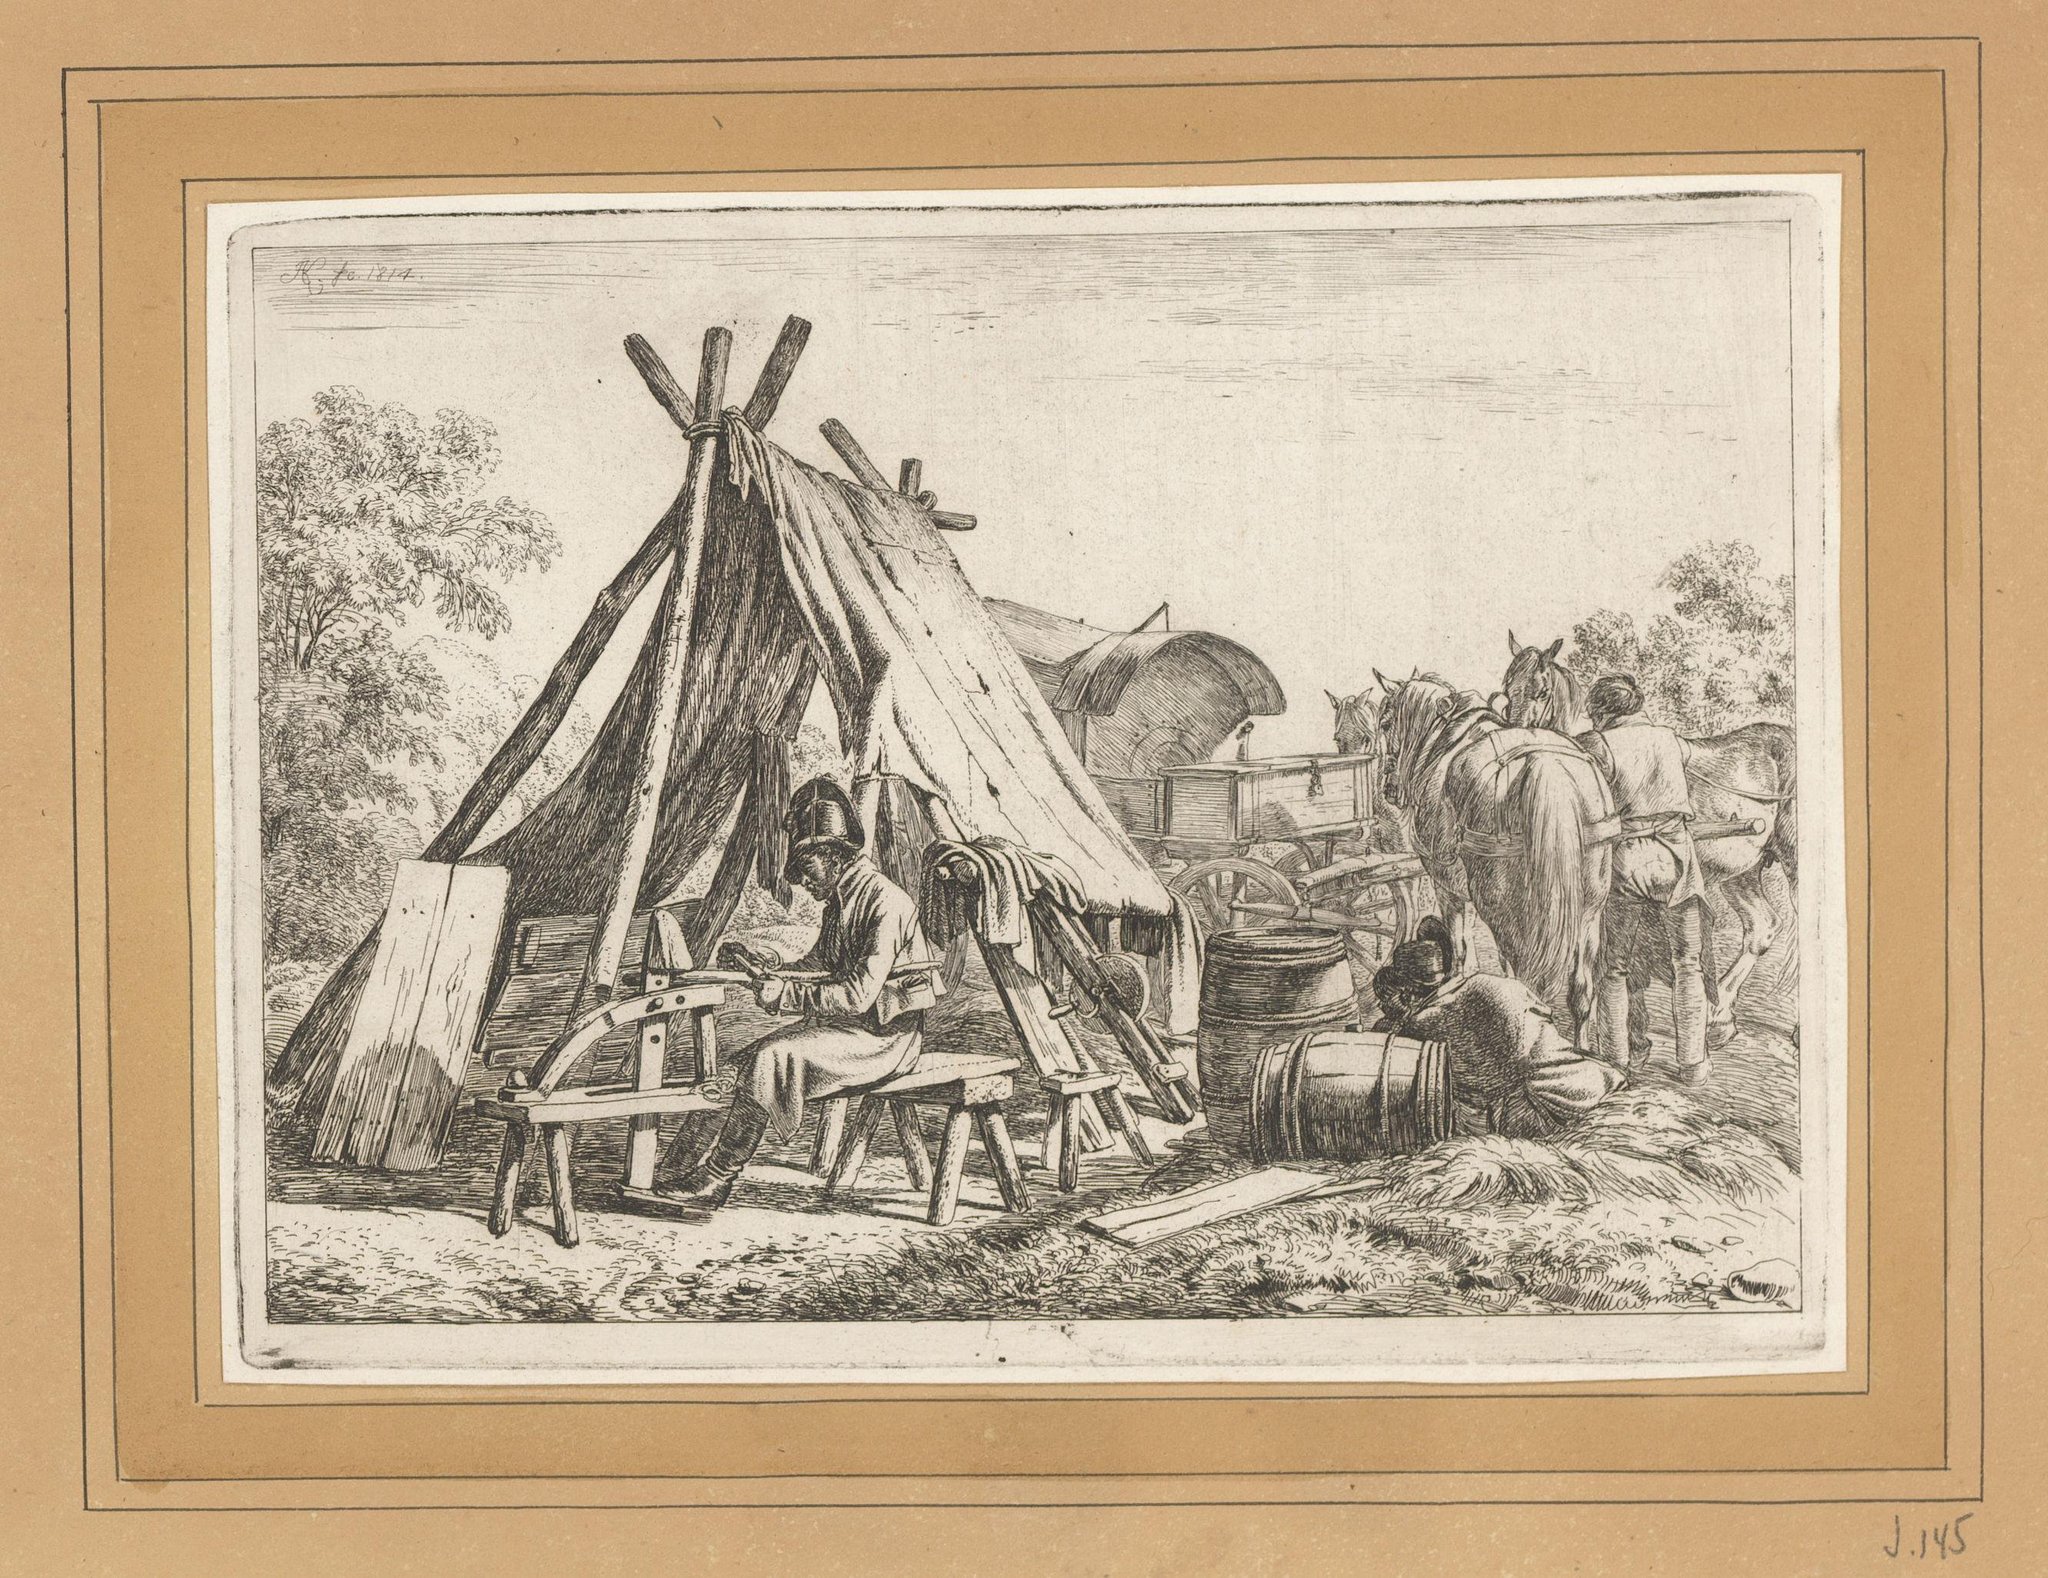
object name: album leaf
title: Soldaat snijdt hout bij een tent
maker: johann adam klein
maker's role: draughtsman, print maker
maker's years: 1792-1875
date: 1814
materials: paper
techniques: etching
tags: recreation ~ the soldier off duty, handicrafts ~ wood, timber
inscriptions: : Lugt 2760, collector's mark: Lugt 2228